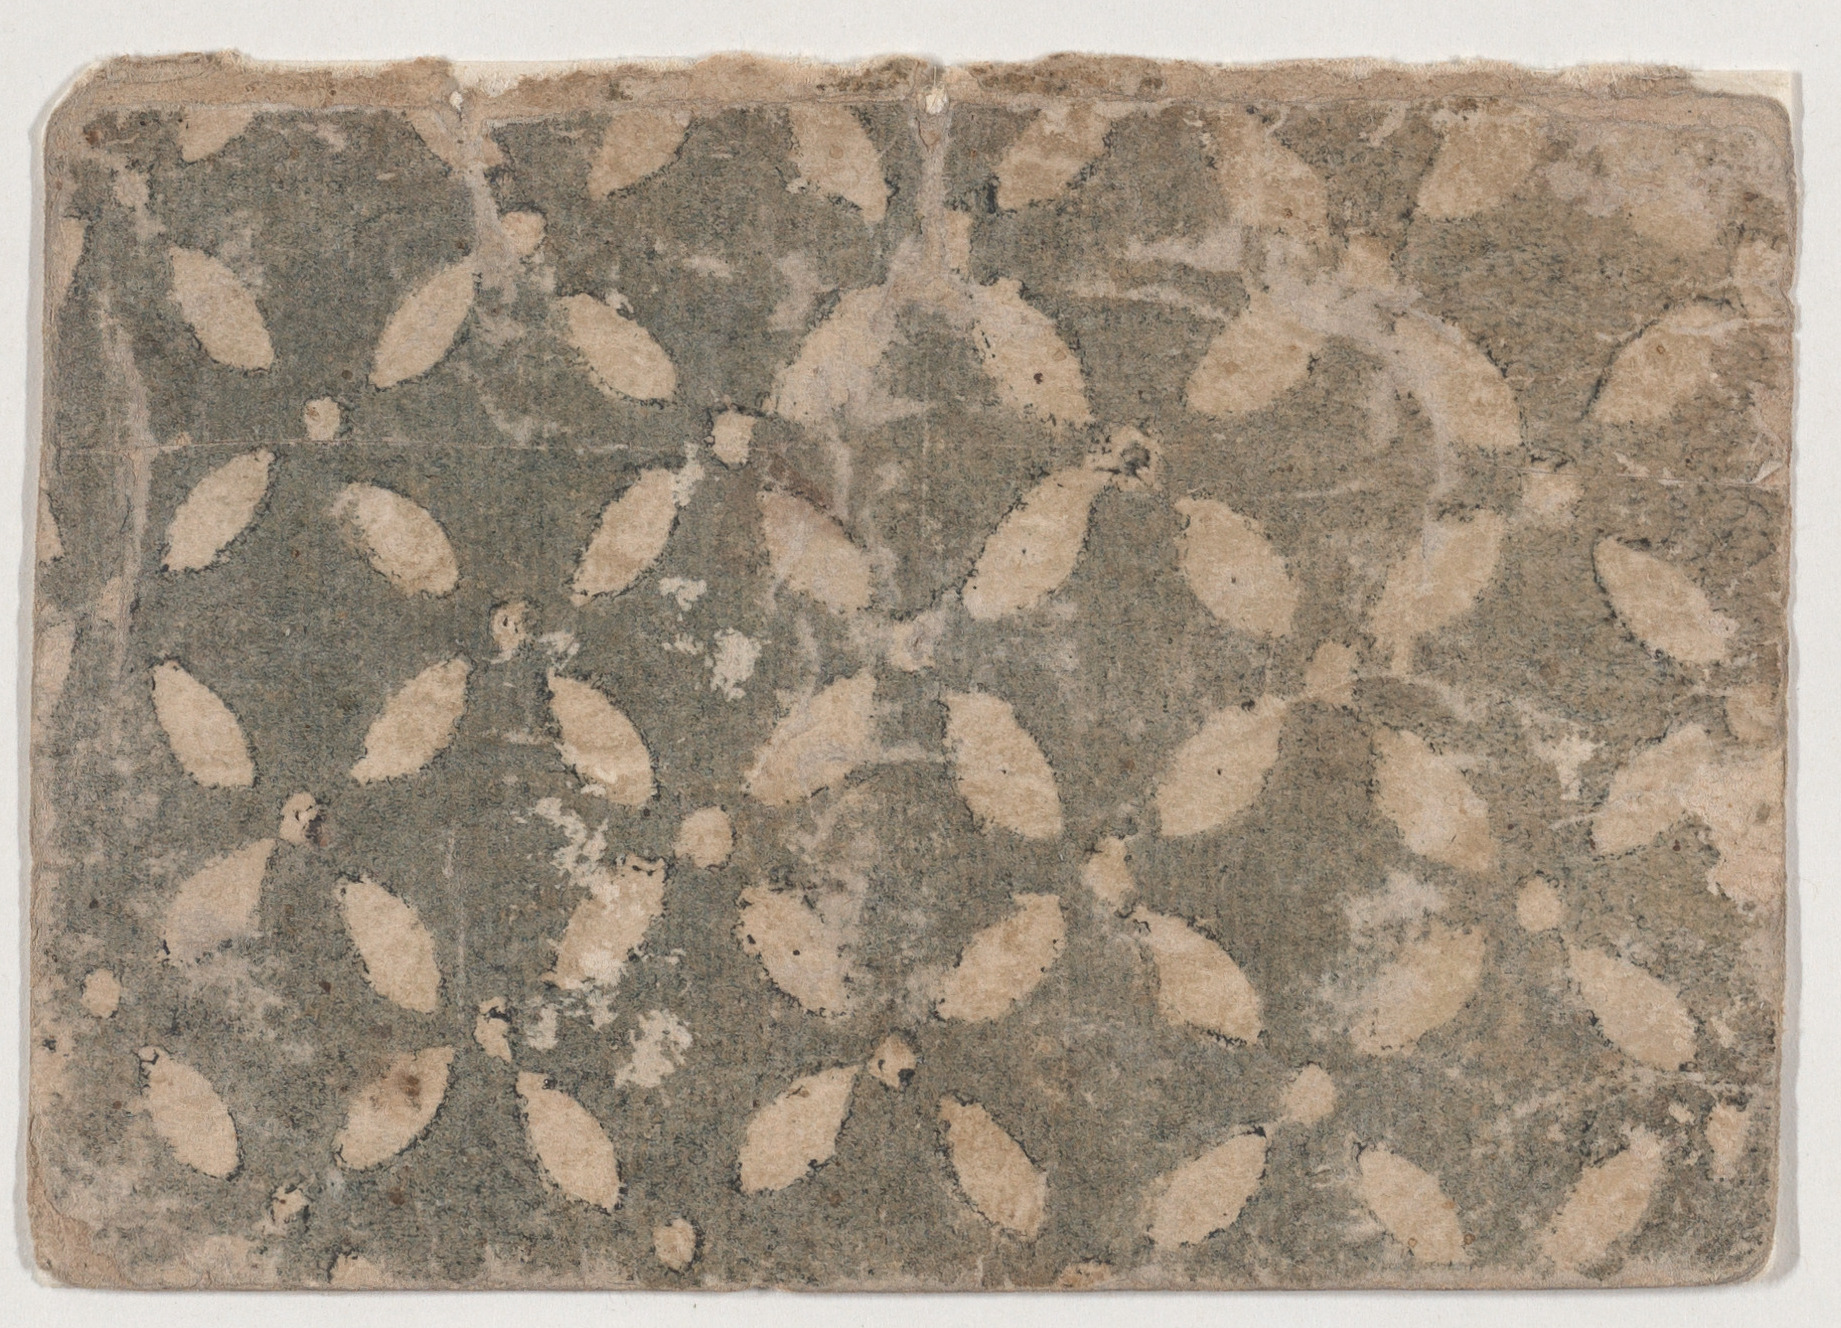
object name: print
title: Sheet with faded floral pattern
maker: Anonymous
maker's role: artist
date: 1801-1900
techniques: relief print